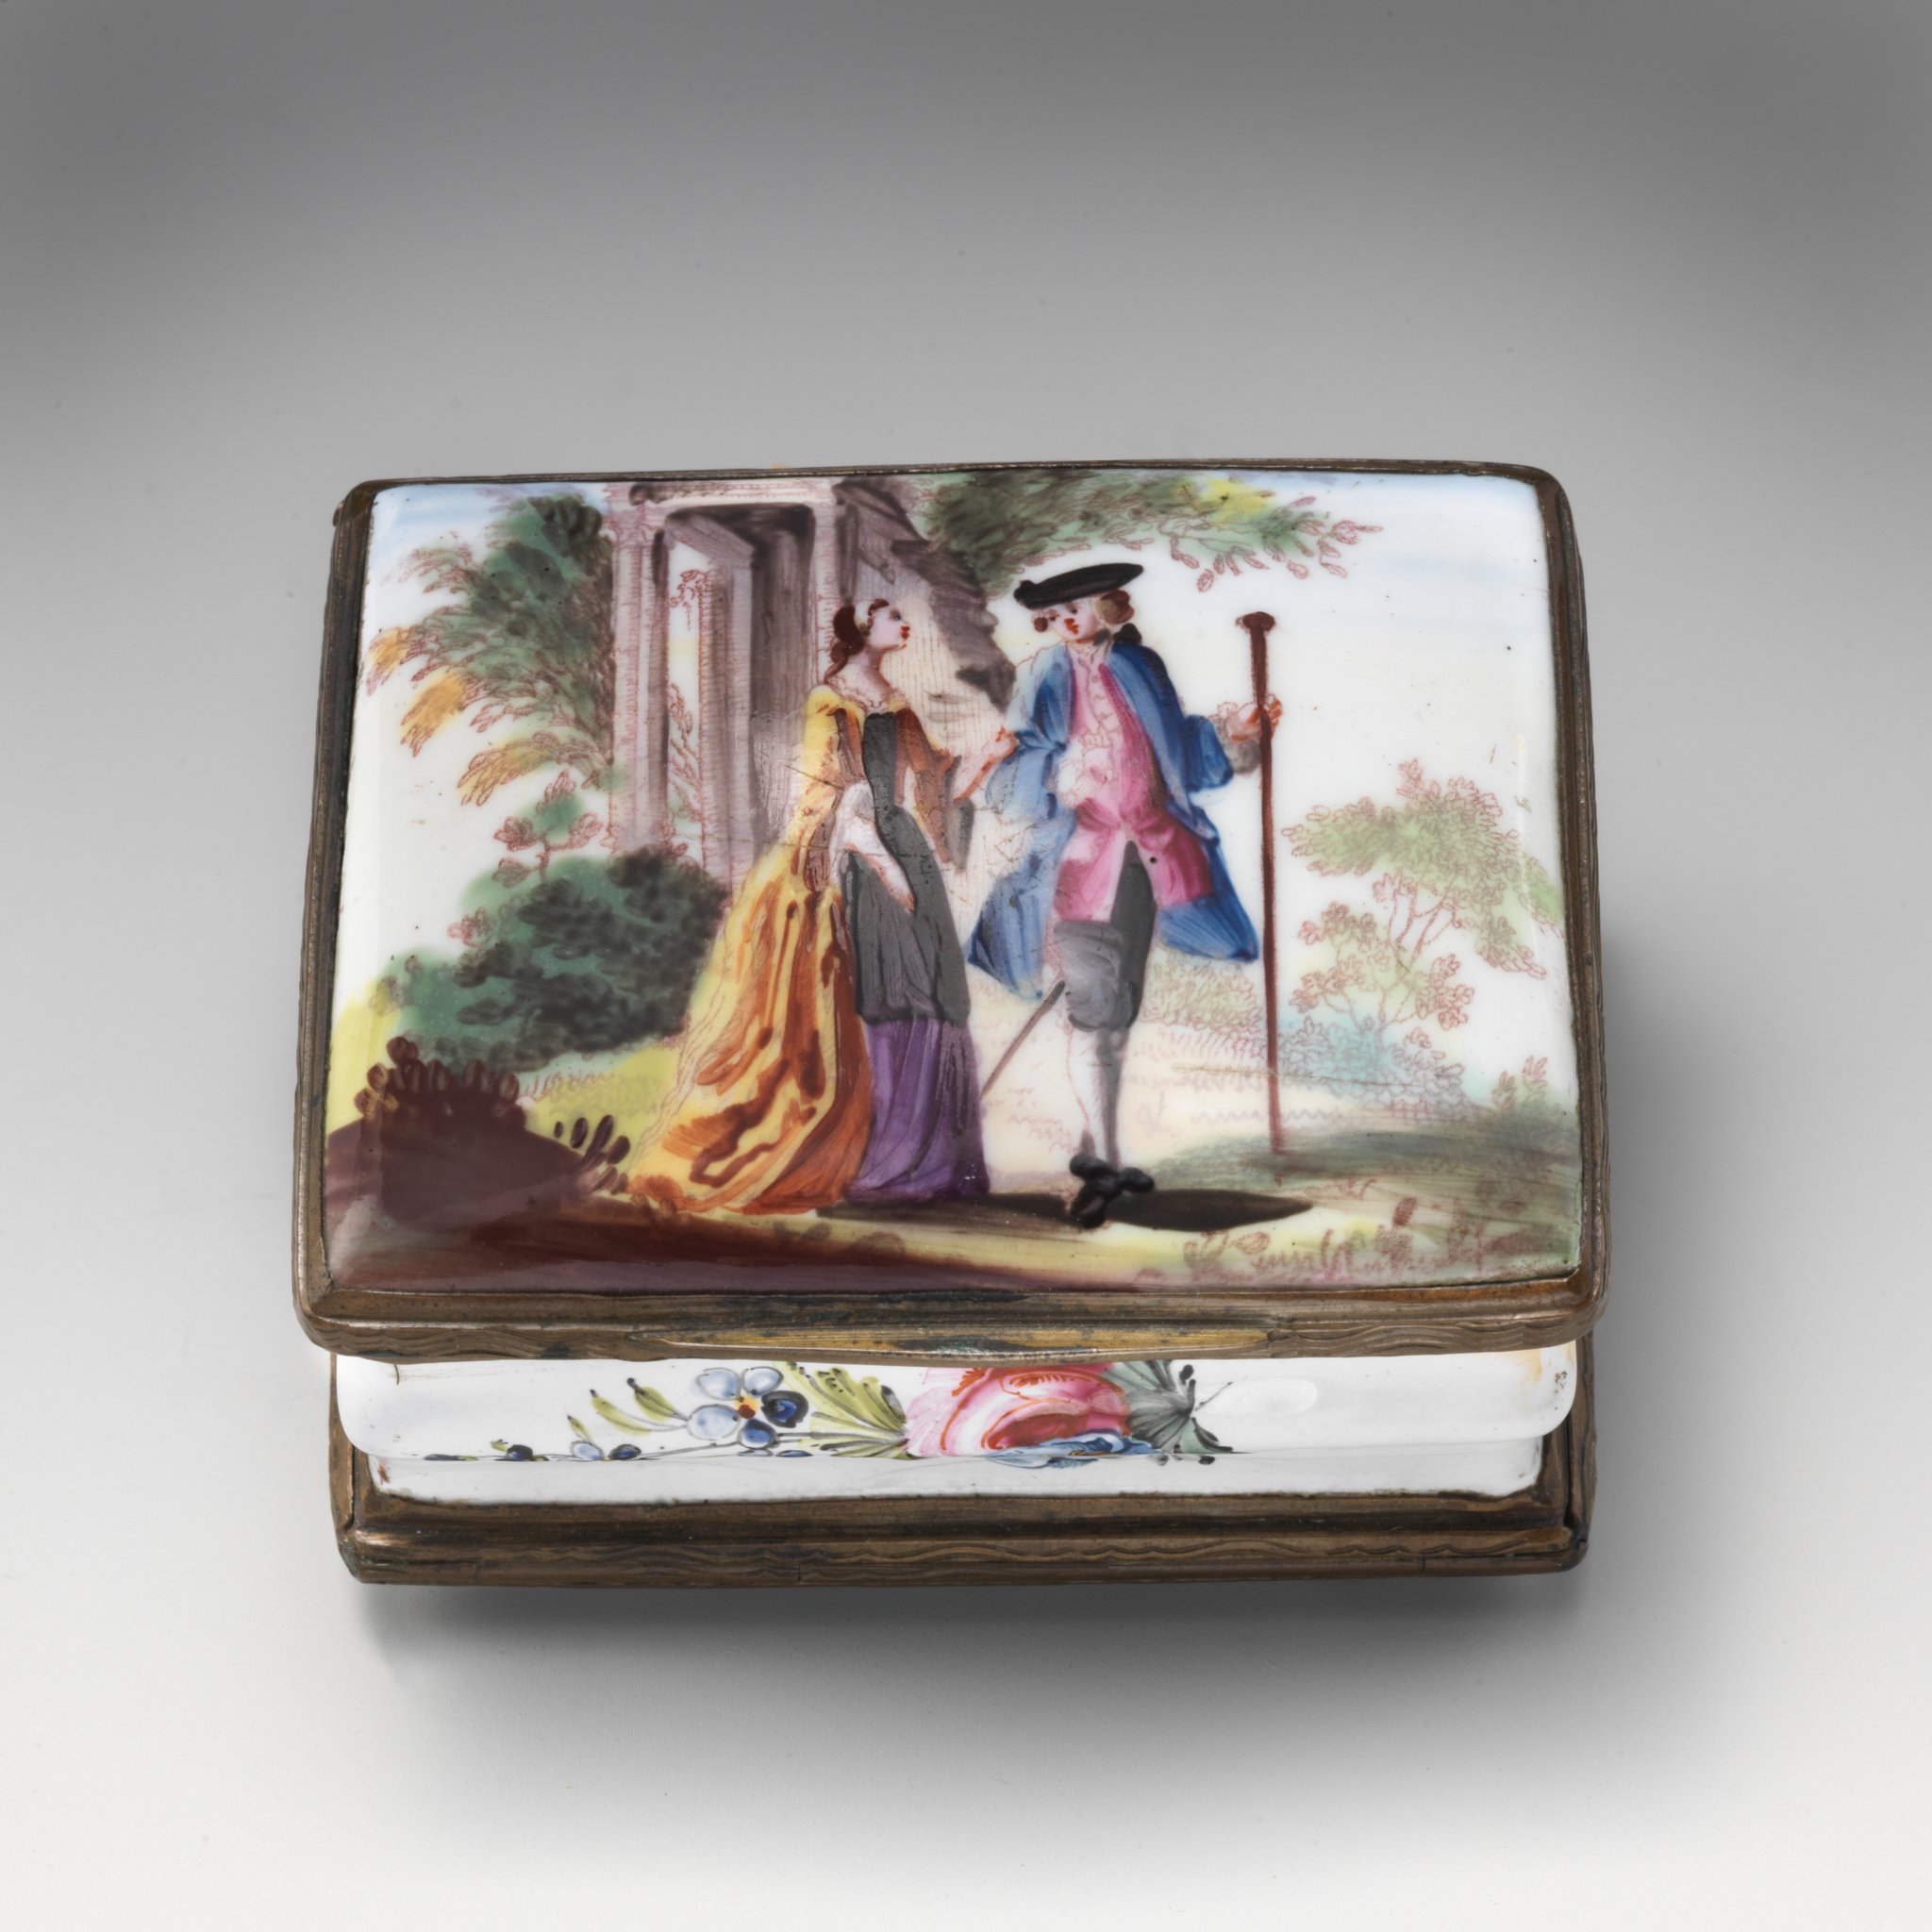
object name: double snuffbox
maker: robert sayer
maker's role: publisher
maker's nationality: british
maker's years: 1725-1794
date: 1755-1760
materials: copper, enamel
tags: men,women,trees